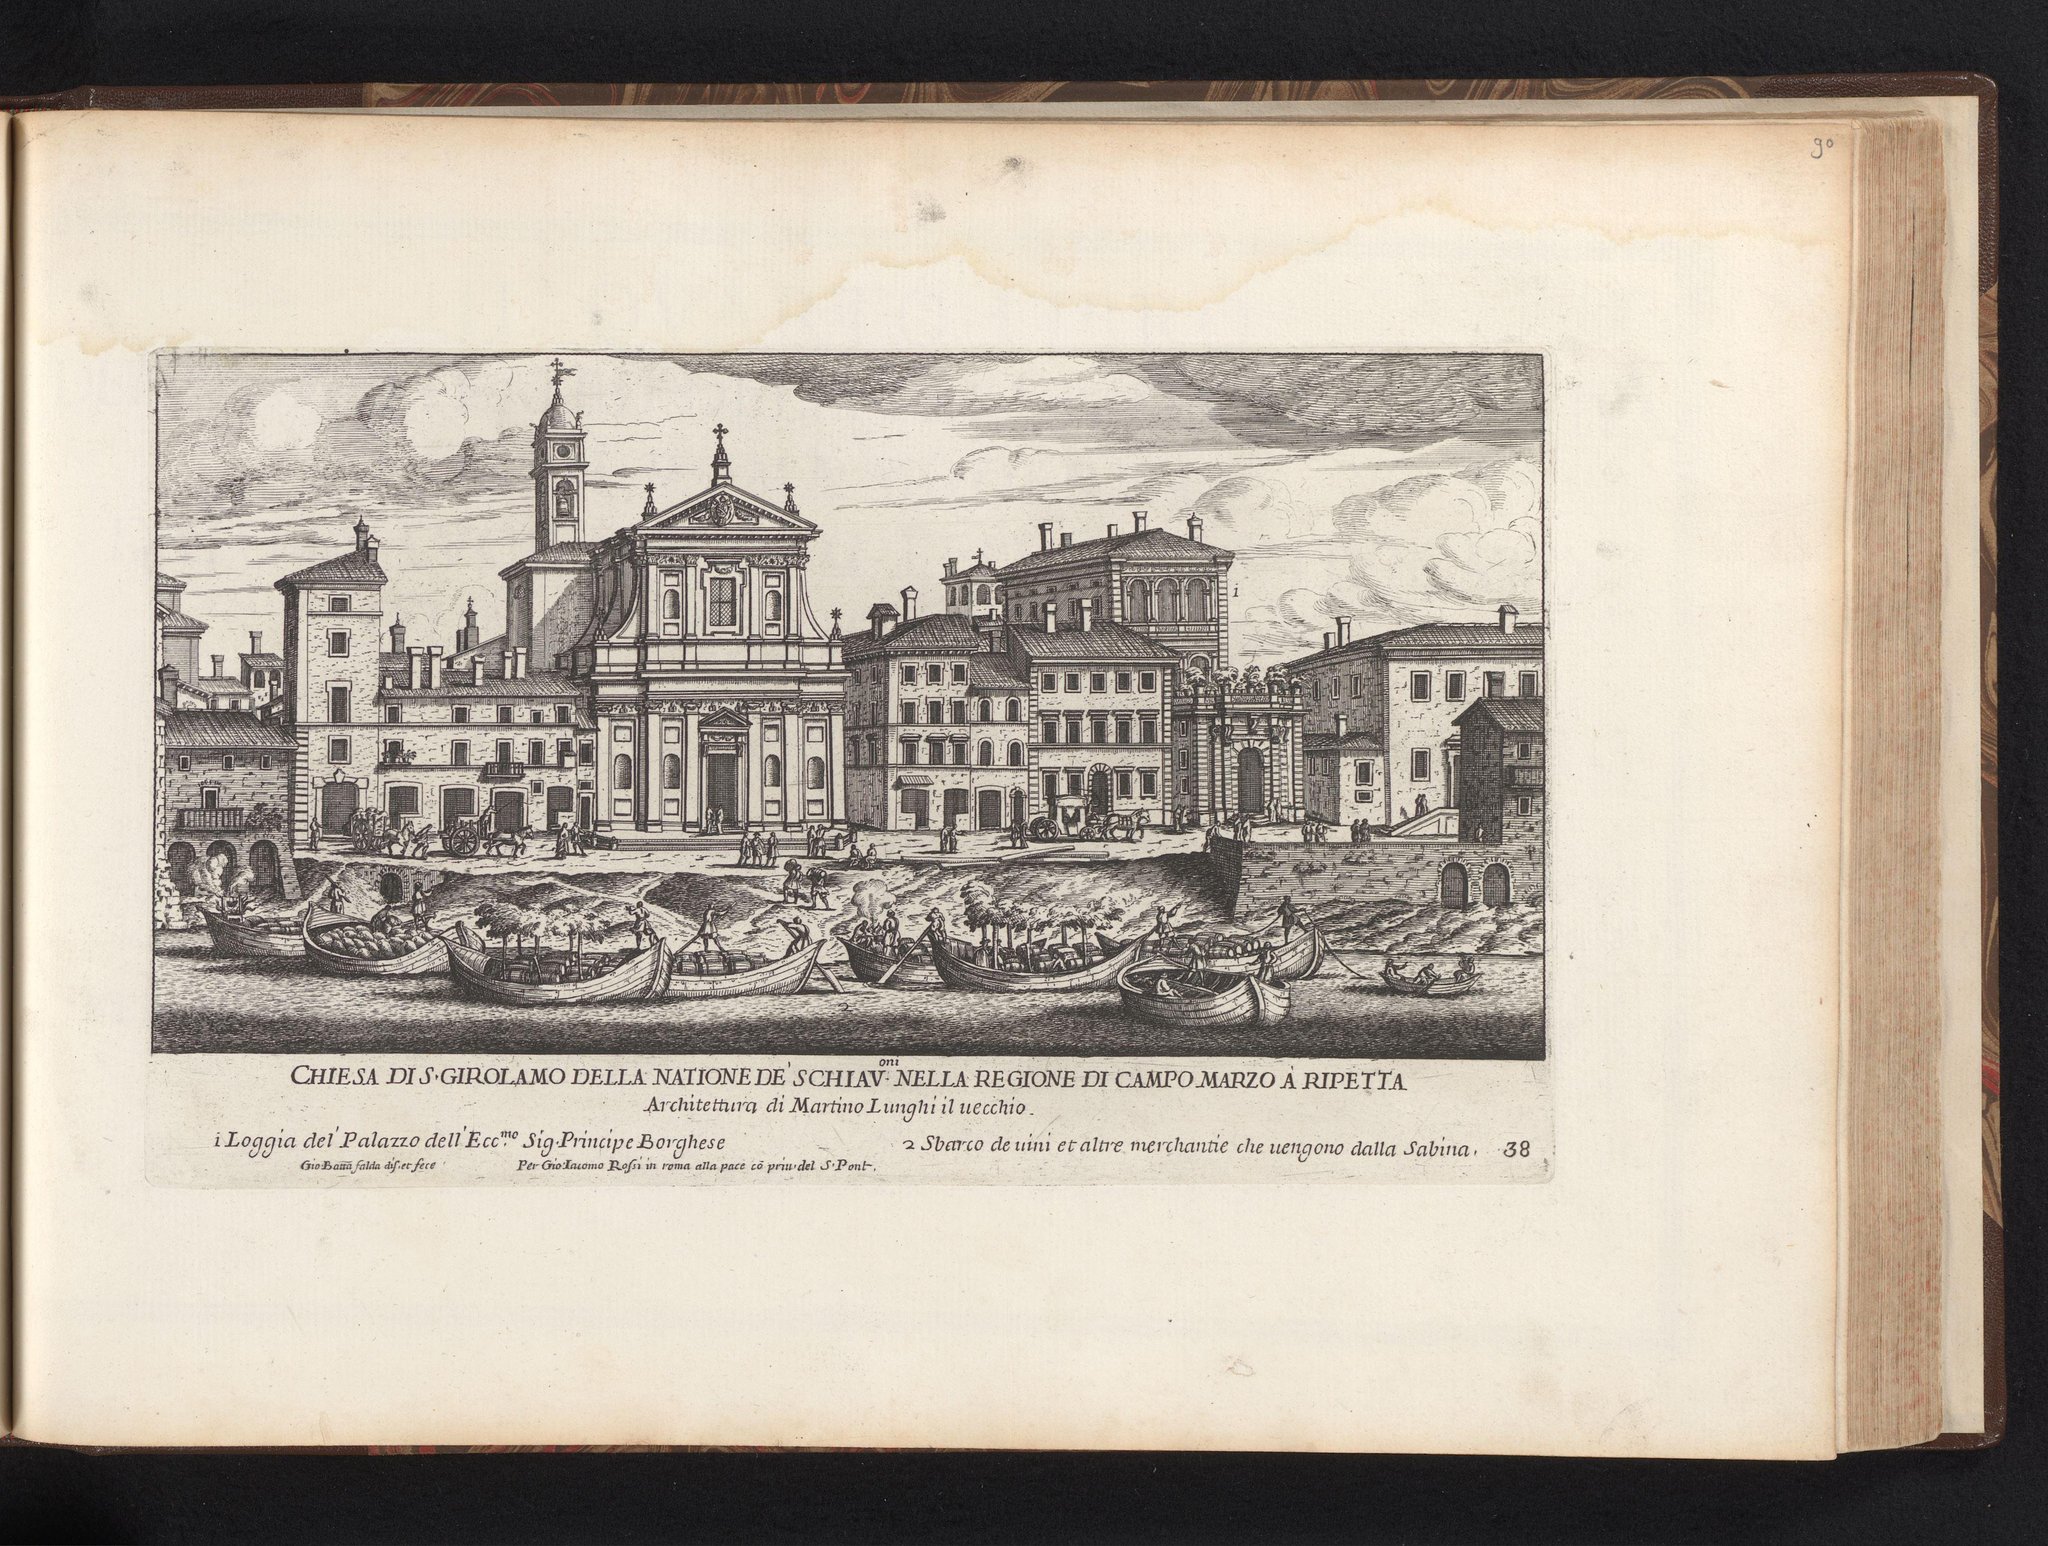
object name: print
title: Il terzo libro del'novo teatro delle chiese di Roma date in luce sotto il felice pontificato di nostro signore papa Clemente IX... (libro terzo)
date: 1669-1670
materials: paper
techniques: etching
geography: italy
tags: city-view, and landscape with man-made constructions, church (exterior)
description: Deze titelprent maakt deel uit van een reeks van 38 prenten met voorstellingen van kerken in Rome. Samen met vier andere reeksen vormt het de grote reeks: 'Il nuovo teatro di Roma moderna'.